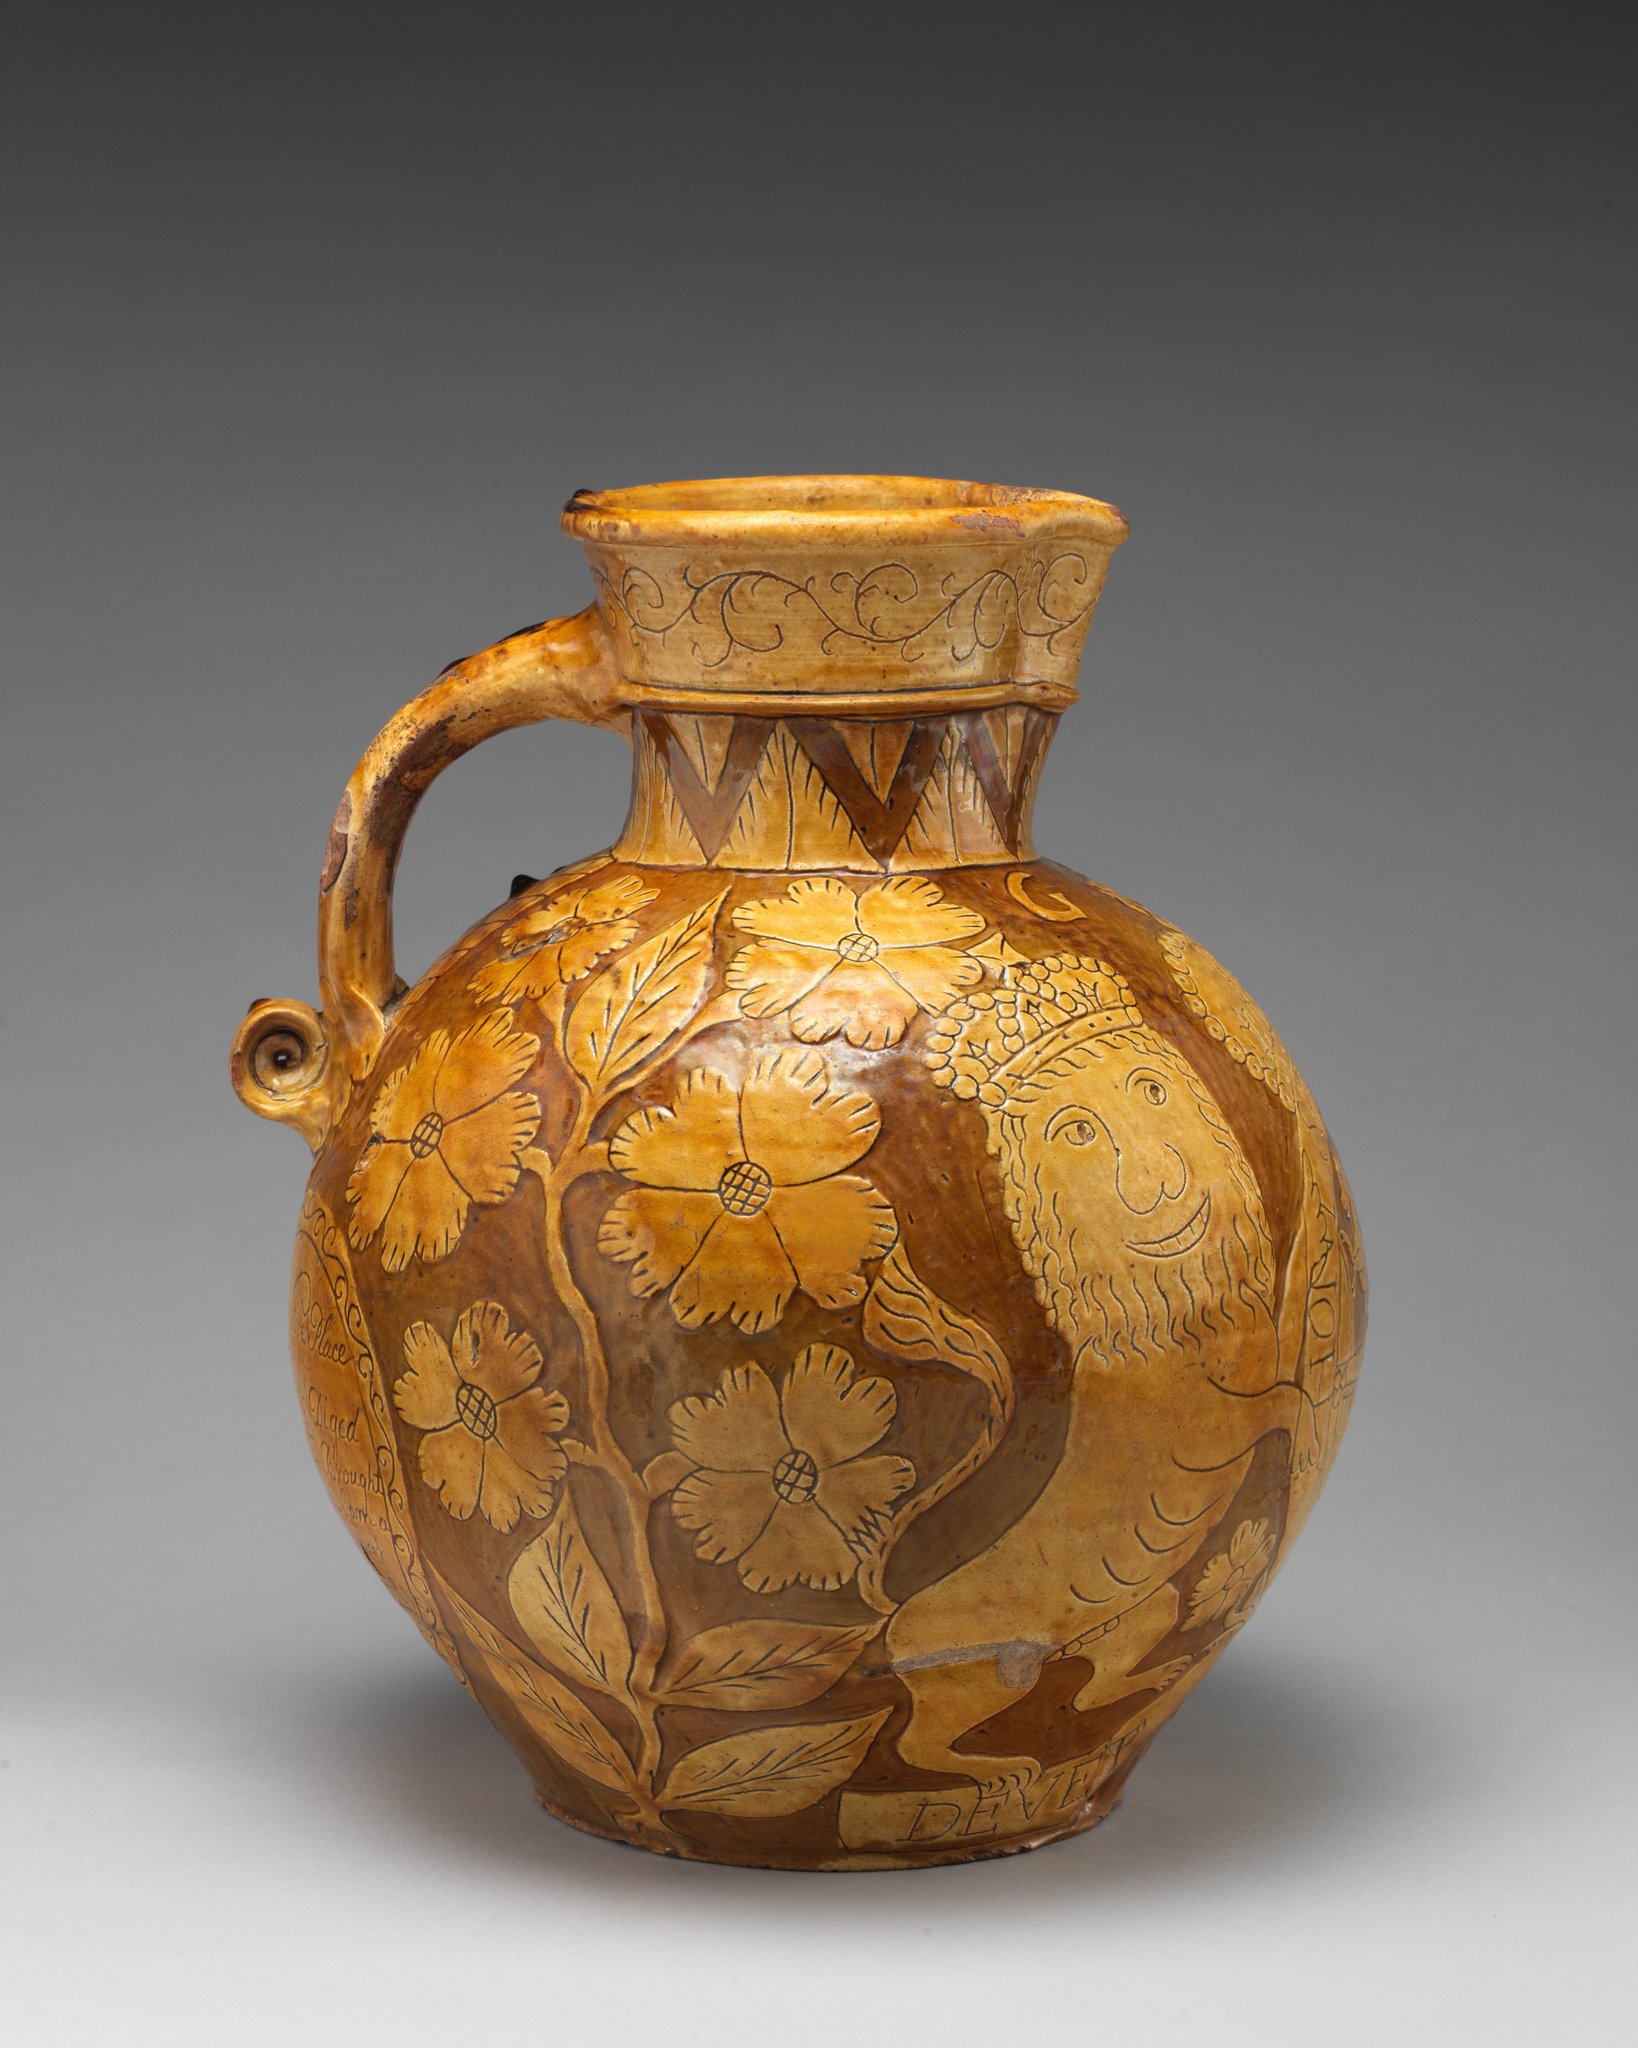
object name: harvest jug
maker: robert burnal of cutcombe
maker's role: artist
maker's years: 1700-1800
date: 1781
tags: unicorns,flowers